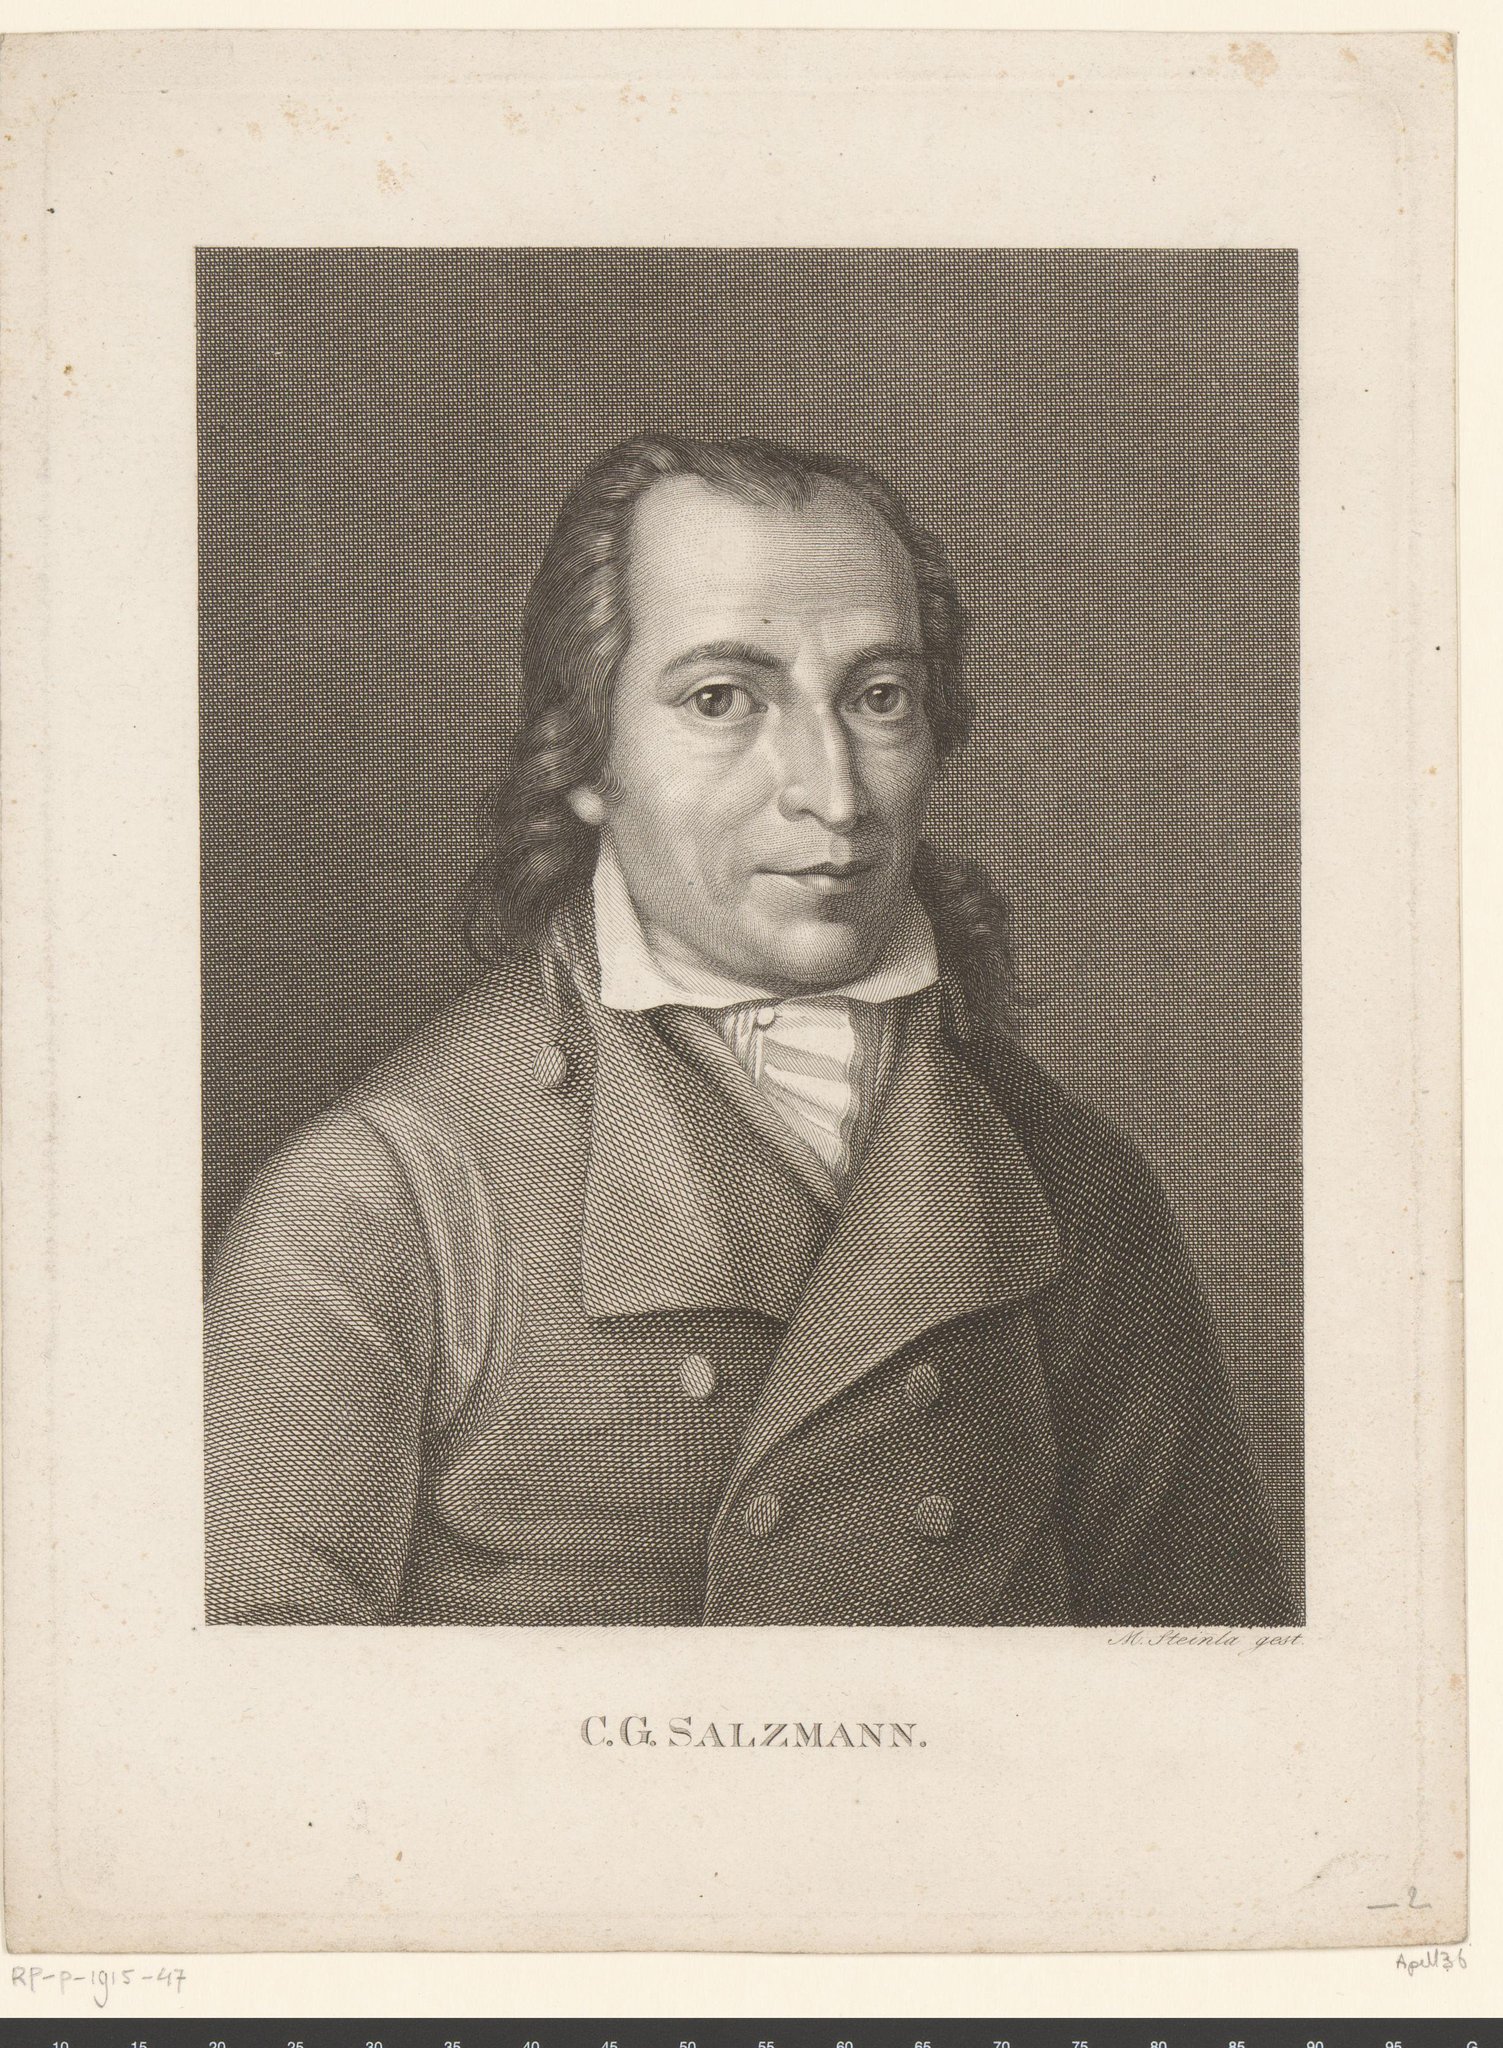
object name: print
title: Portret van Christian Gotthilf Salzmann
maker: moritz steinla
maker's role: painter, print maker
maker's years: 1791-1858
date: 1801-1858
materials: paper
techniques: engraving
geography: germany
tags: historical persons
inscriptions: collector's mark: Lugt 2228